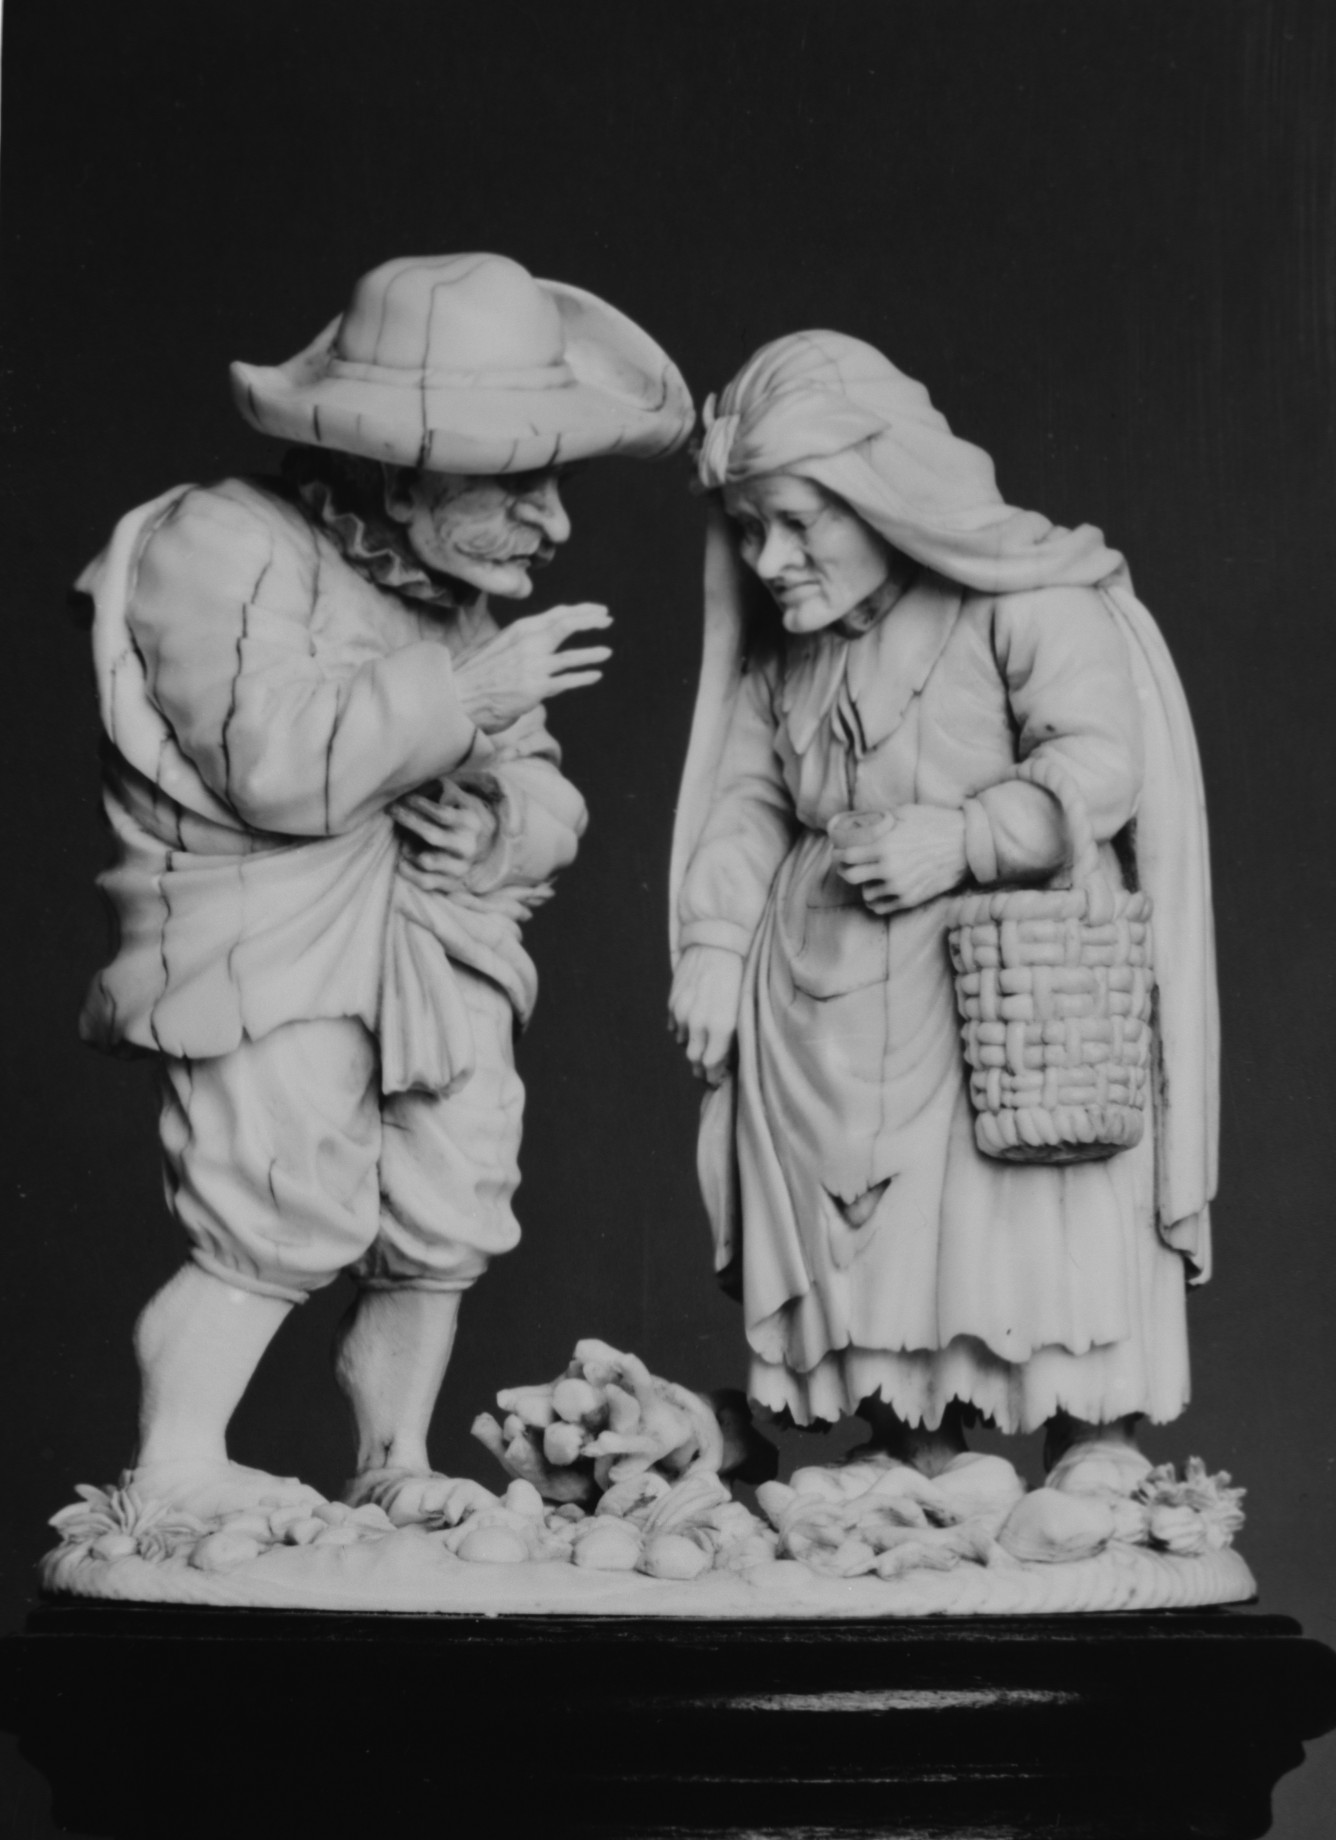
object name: statuette group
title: Old Peasant Couple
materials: ivory, wood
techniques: carving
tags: couples,men,women